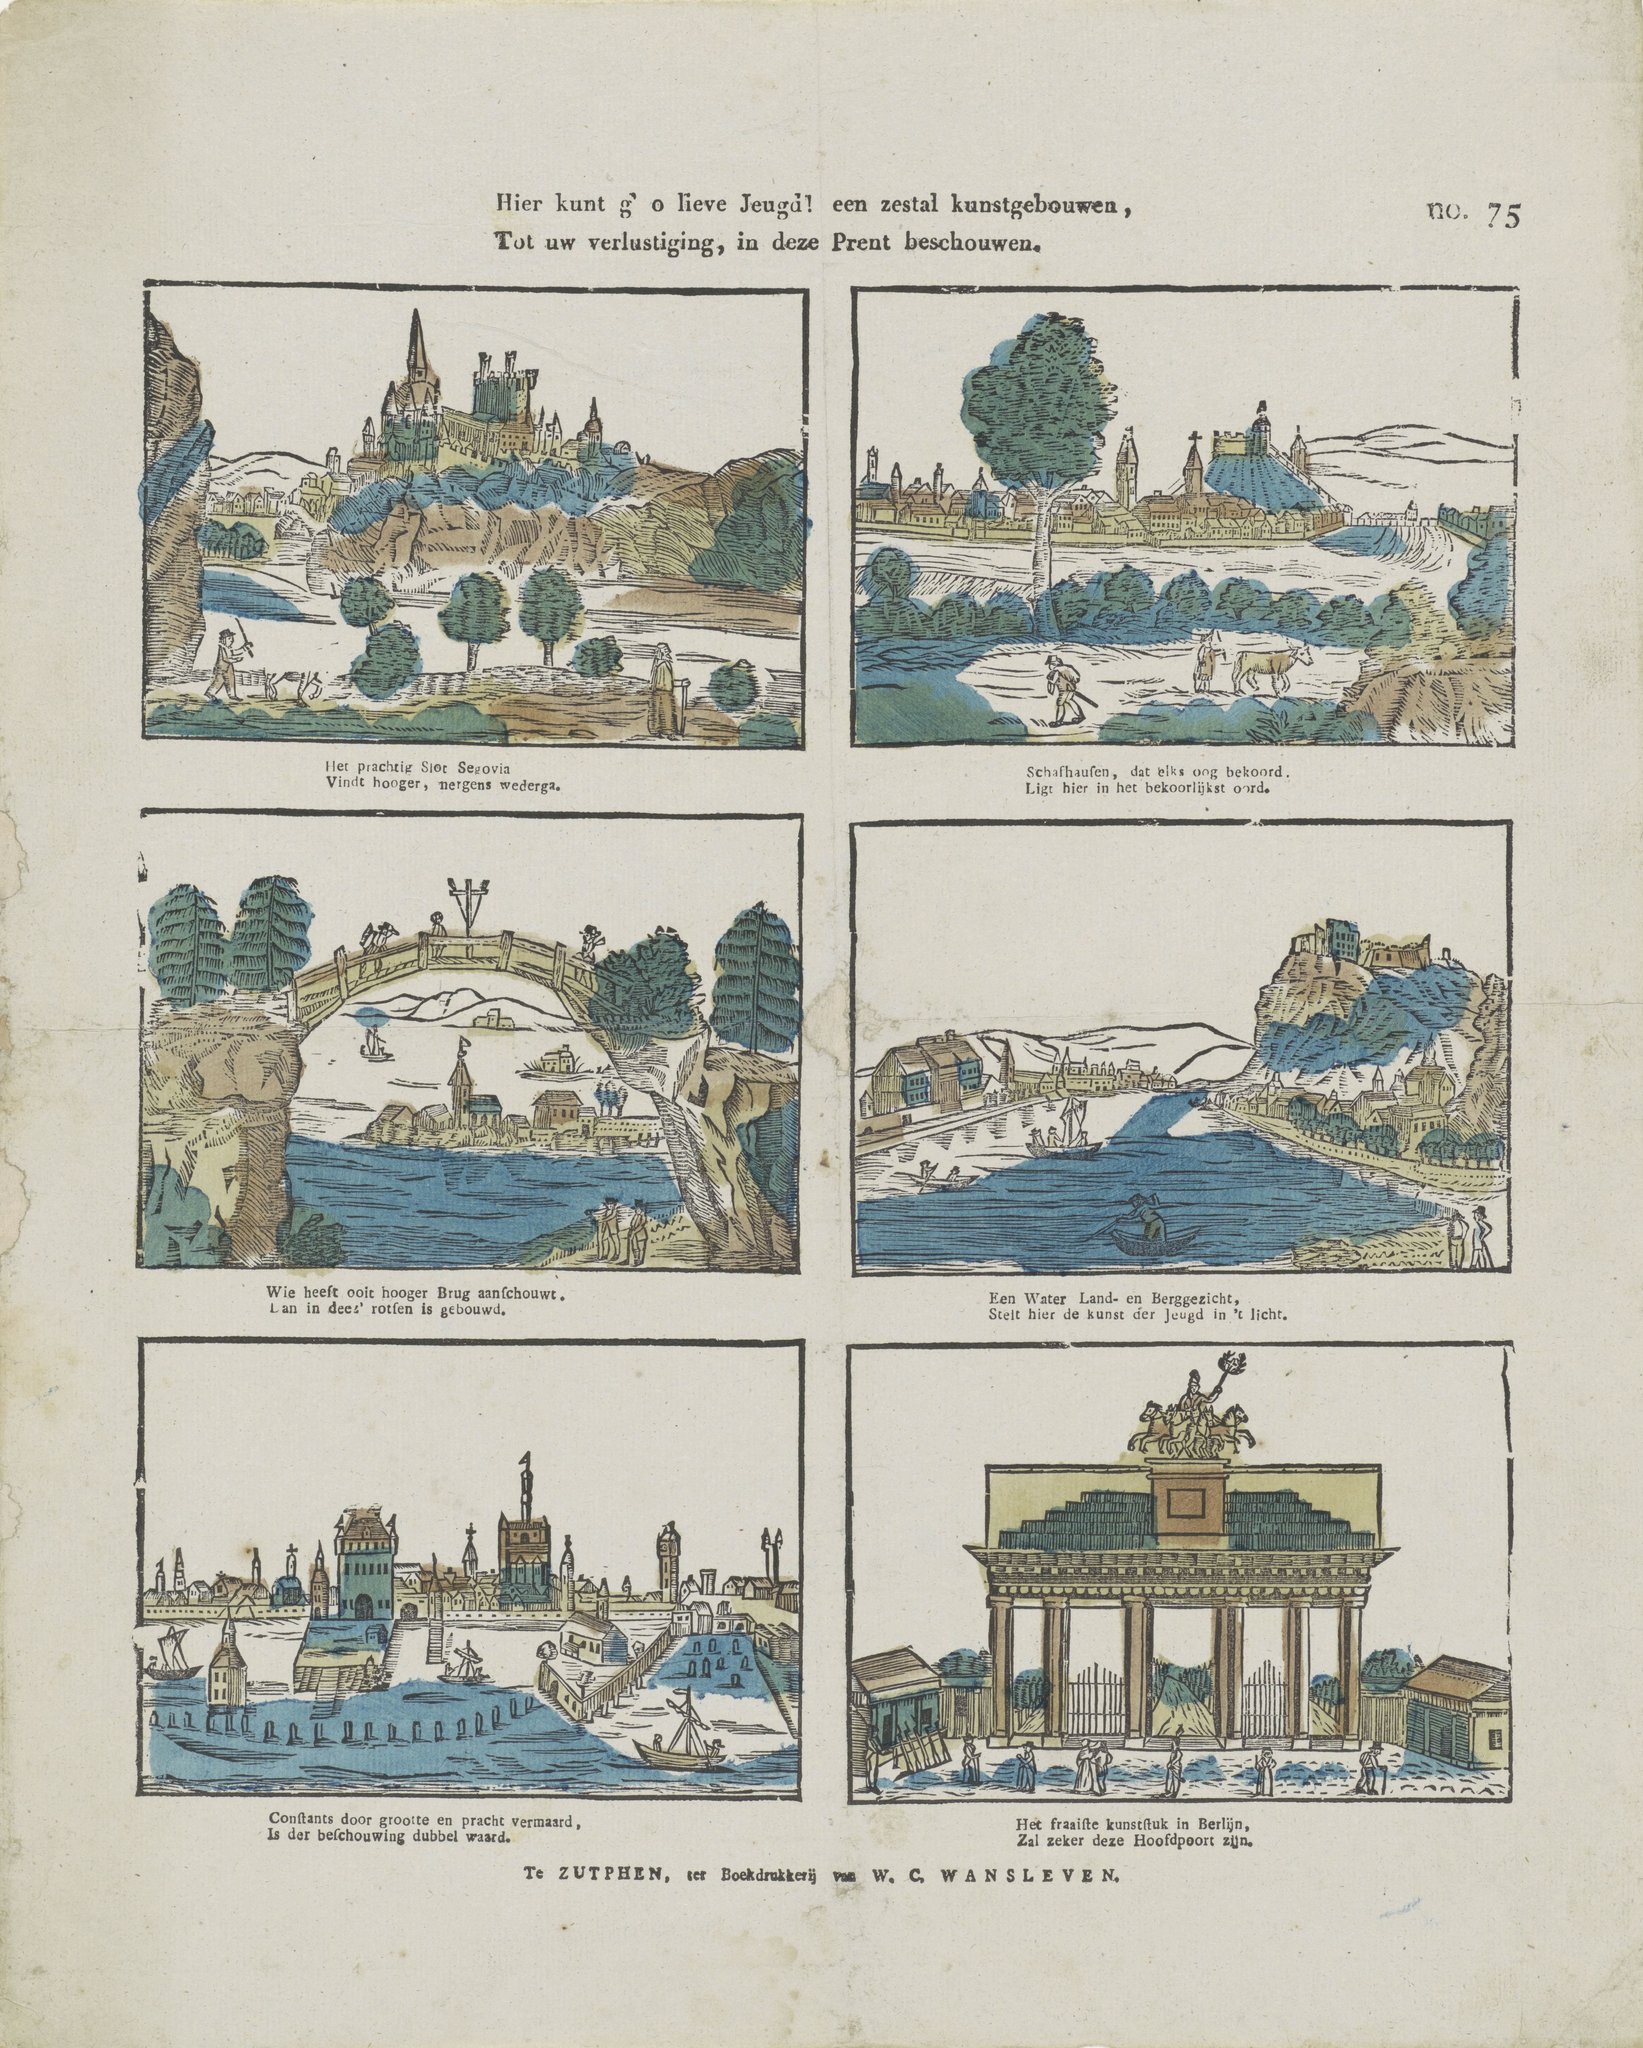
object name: print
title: Hier kunt g'o lieve jeugd! een zestal kunstgebouwen, / Tot uw verlusting, in deze prent beschouwen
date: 1806-1858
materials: paper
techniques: colour, letterpress printing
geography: zutphen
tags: landscape with monument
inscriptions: collector's mark: Lugt 2760, collector's mark: Lugt 2228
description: Blad met 6 voorstellingen van stadsgezichten en monumenten, waaronder het kasteel van Segovia en de Brandenburger Tor. Onder elke afbeelding een tweeregelig vers. Genummerd linksboven: no. 75.